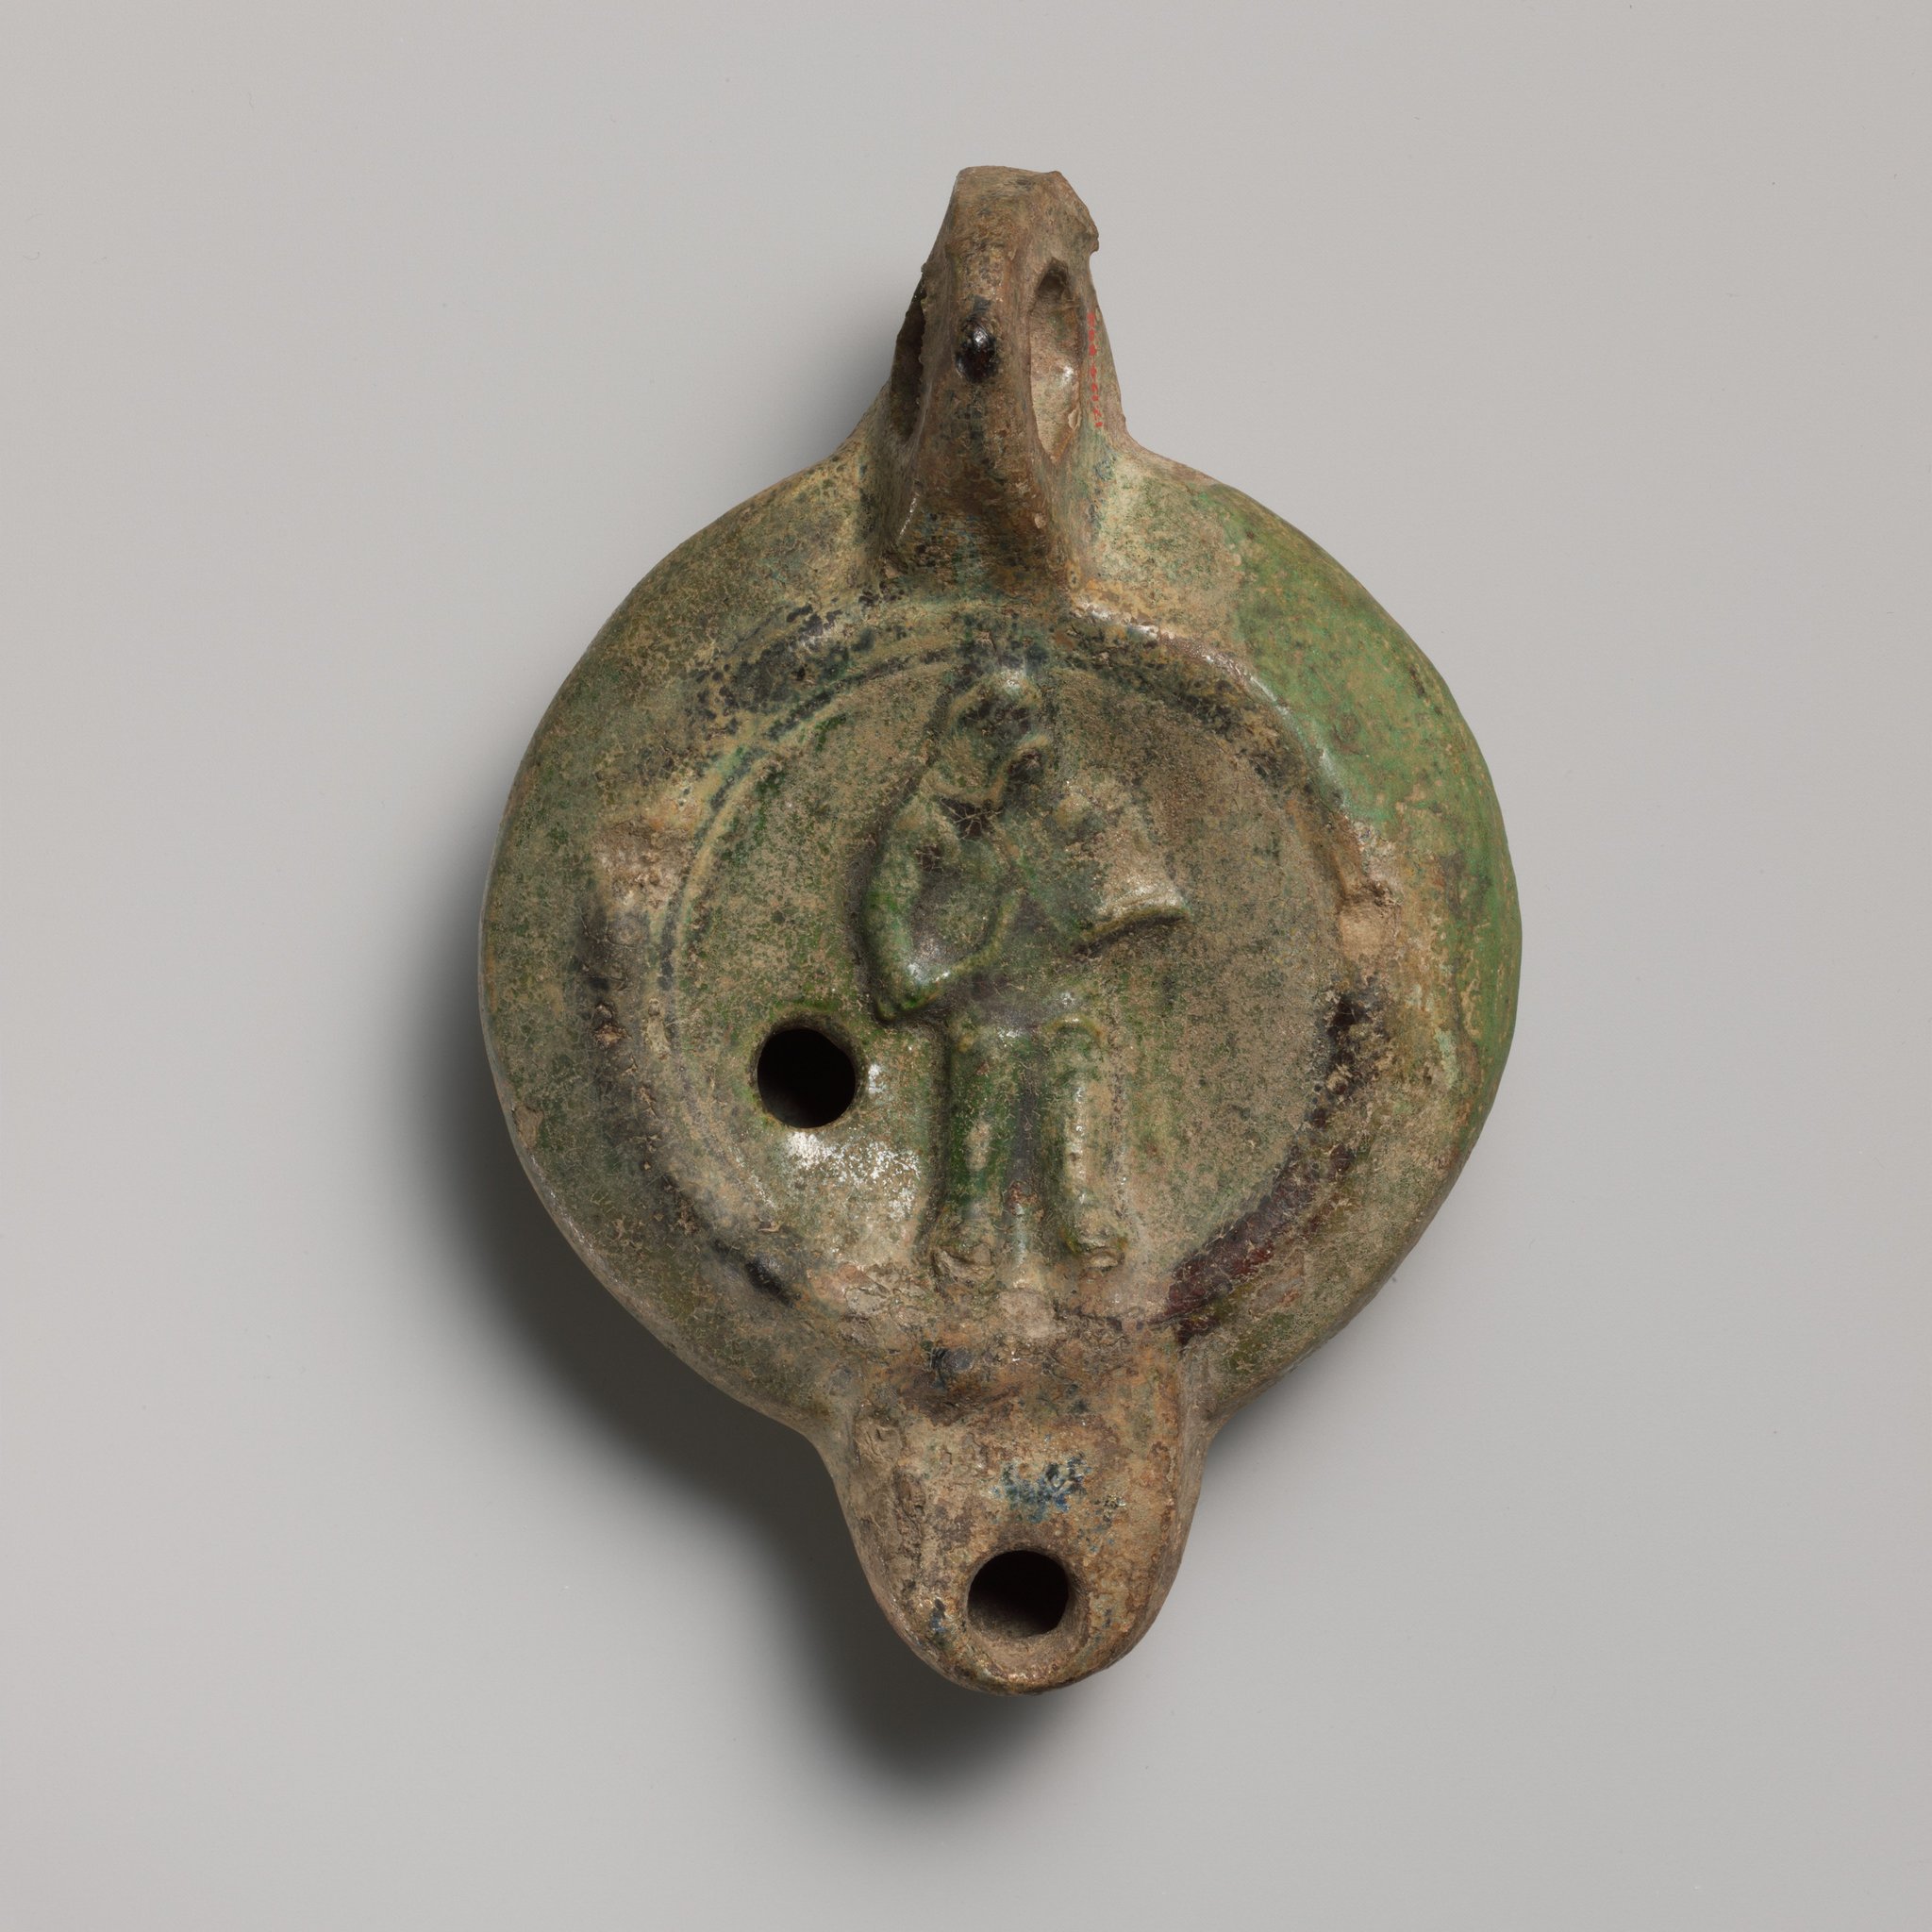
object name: lamp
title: Terracotta lamp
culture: roman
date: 67-200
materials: terracotta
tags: gladiators